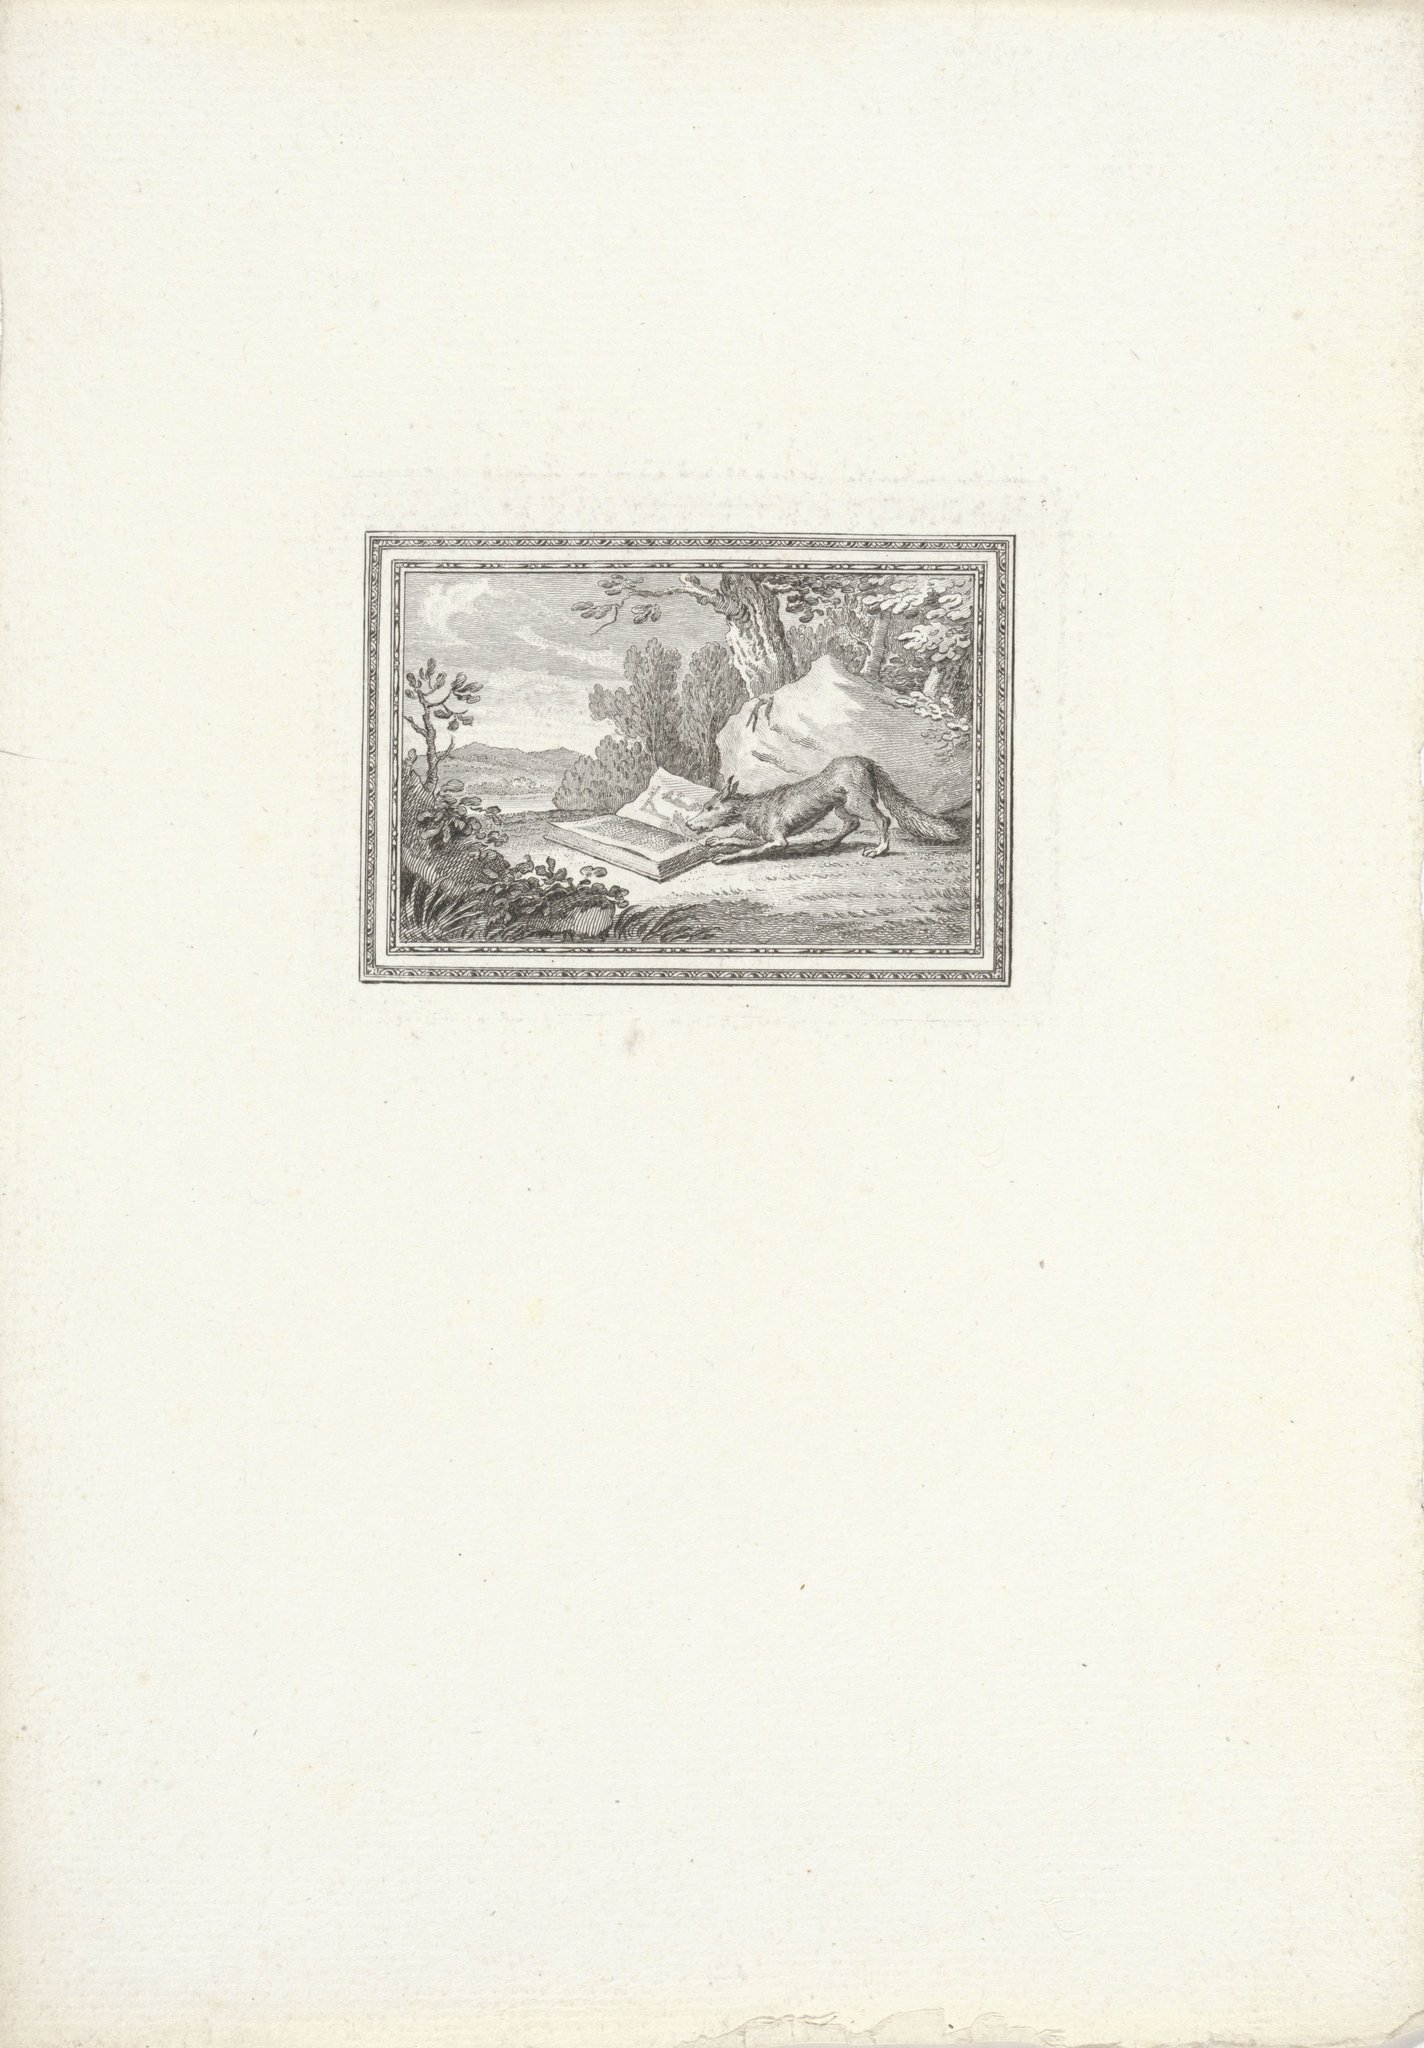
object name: print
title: Vos en een boek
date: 1792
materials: paper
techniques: etching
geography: amsterdam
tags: reading, book, beasts of prey, predatory animals: fox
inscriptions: collector's mark: Lugt 2228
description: Bosgezicht met een vos die een spannend verhaal over een vos en een wolf leest, in het boek dat voor hem ligt. Illustratie bij het verhaal 'De vos en het boek' uit 'Fabelen voor de Nederlandsche jeugd'.